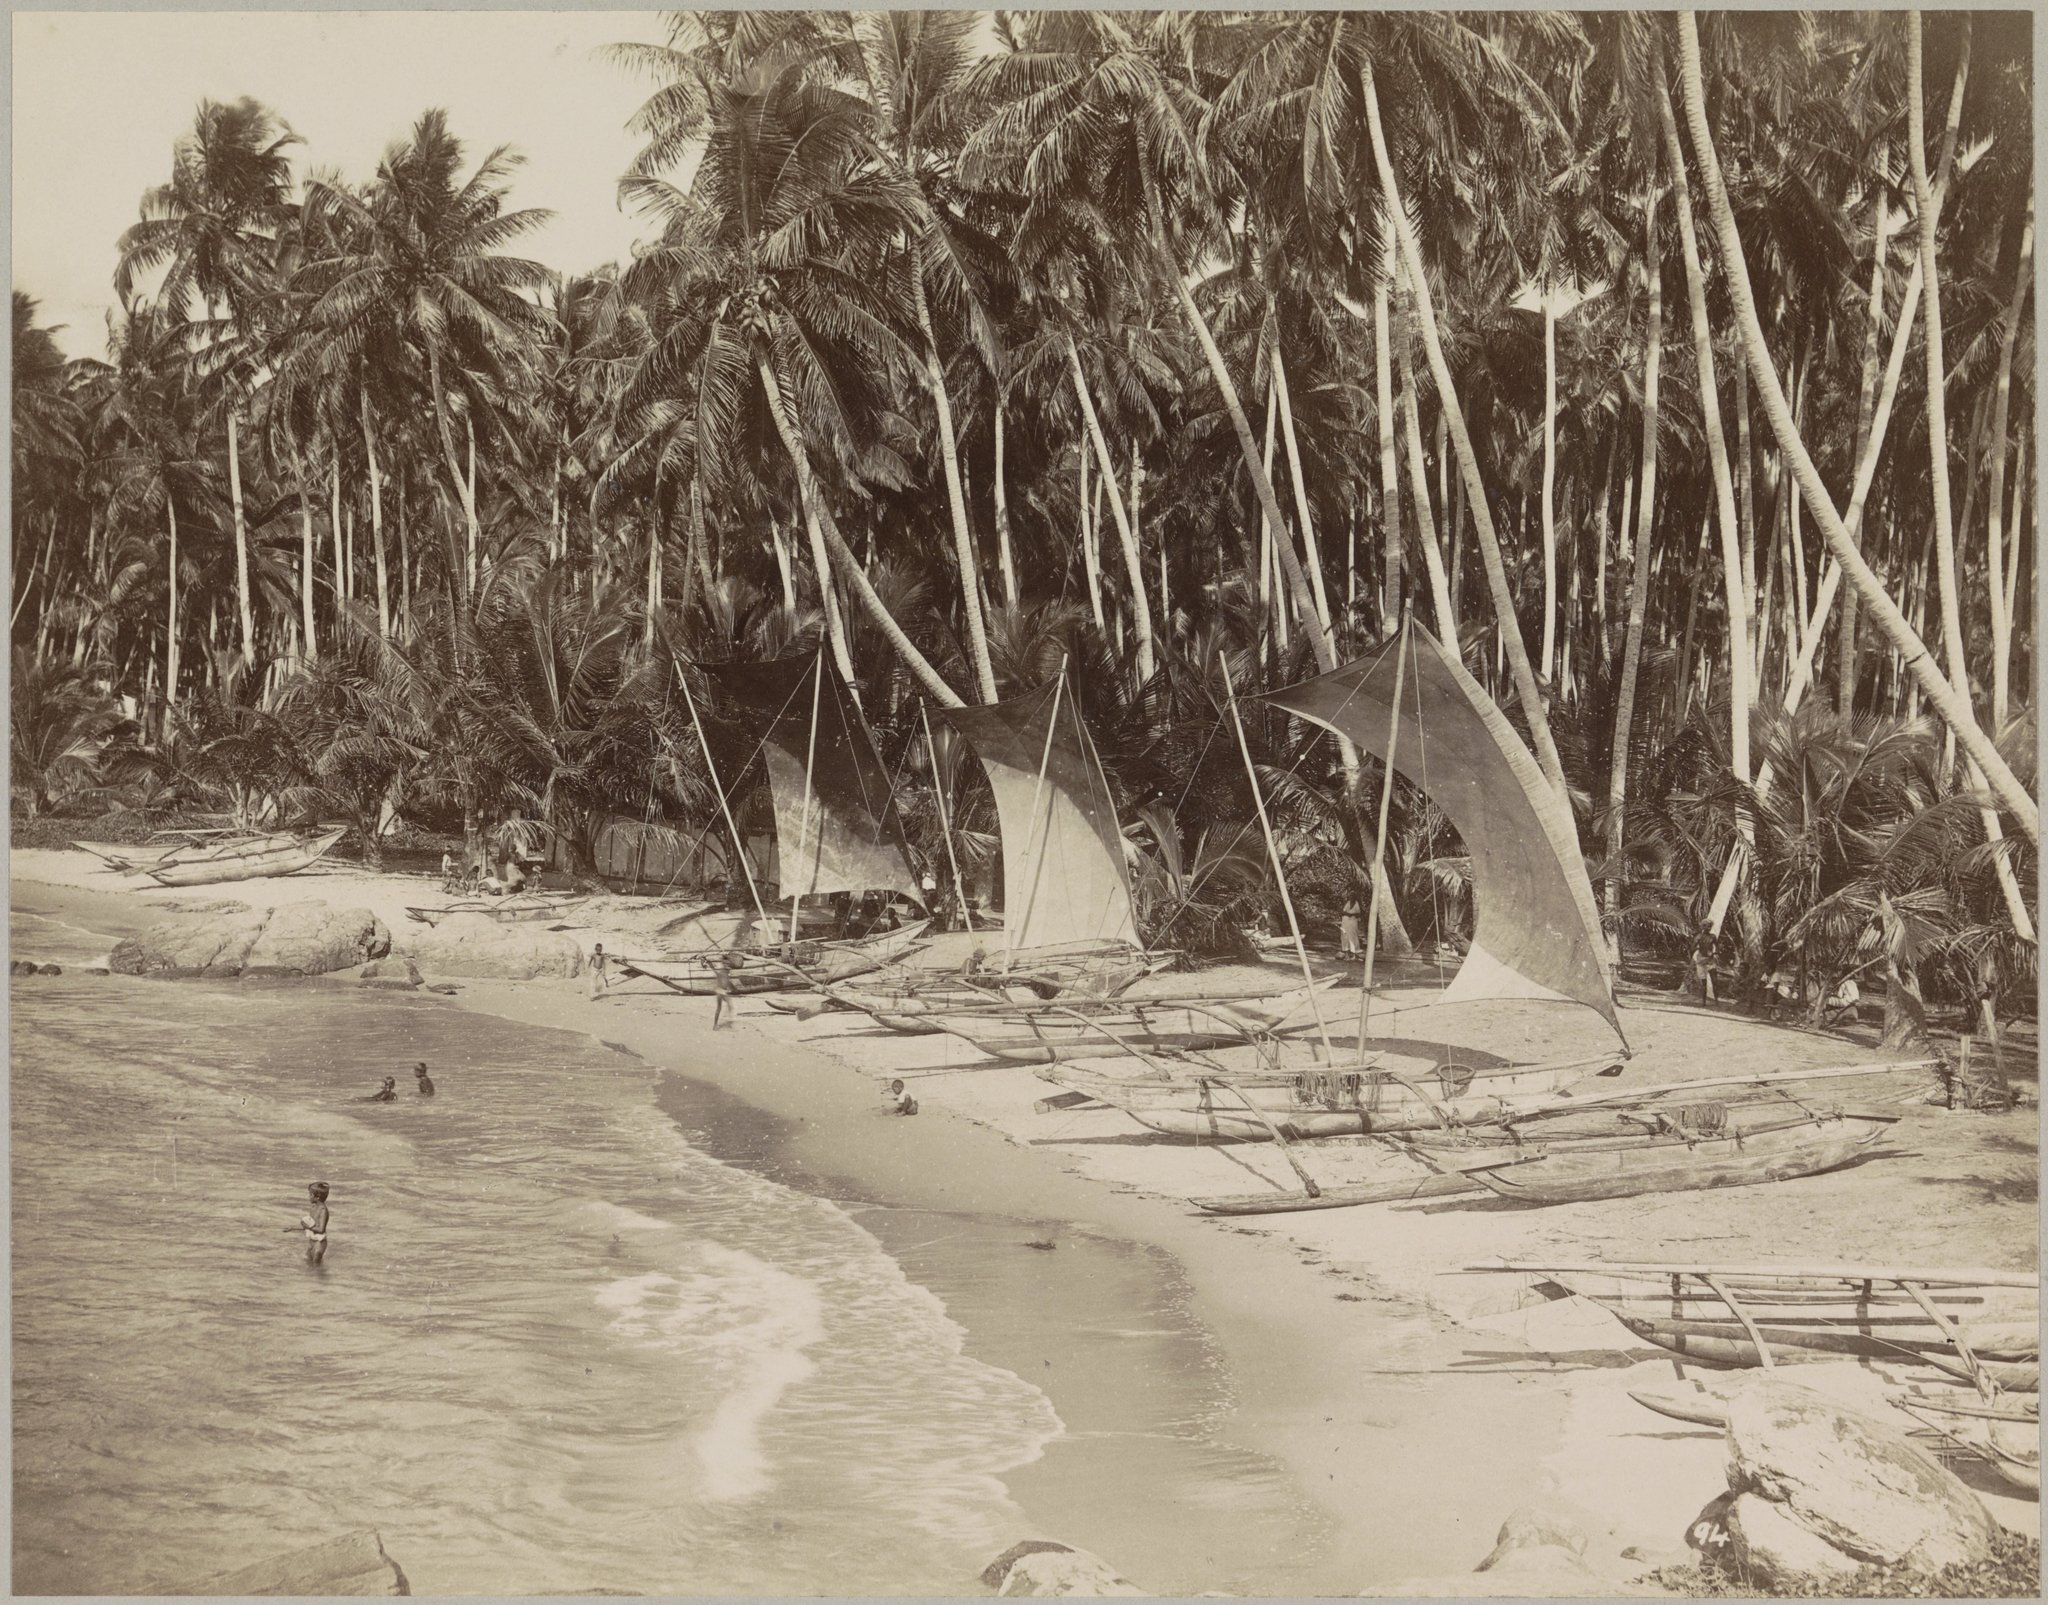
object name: photograph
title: Beach with palm trees and boats, Galle, Sri Lanka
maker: Anonymous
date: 1895-1915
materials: cardboard, paper, photographic support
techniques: albumen print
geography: galle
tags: galle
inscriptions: inscription: ‘14. Galle.’, number: ‘94’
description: Strand met in het midden drie boten met zeilen.